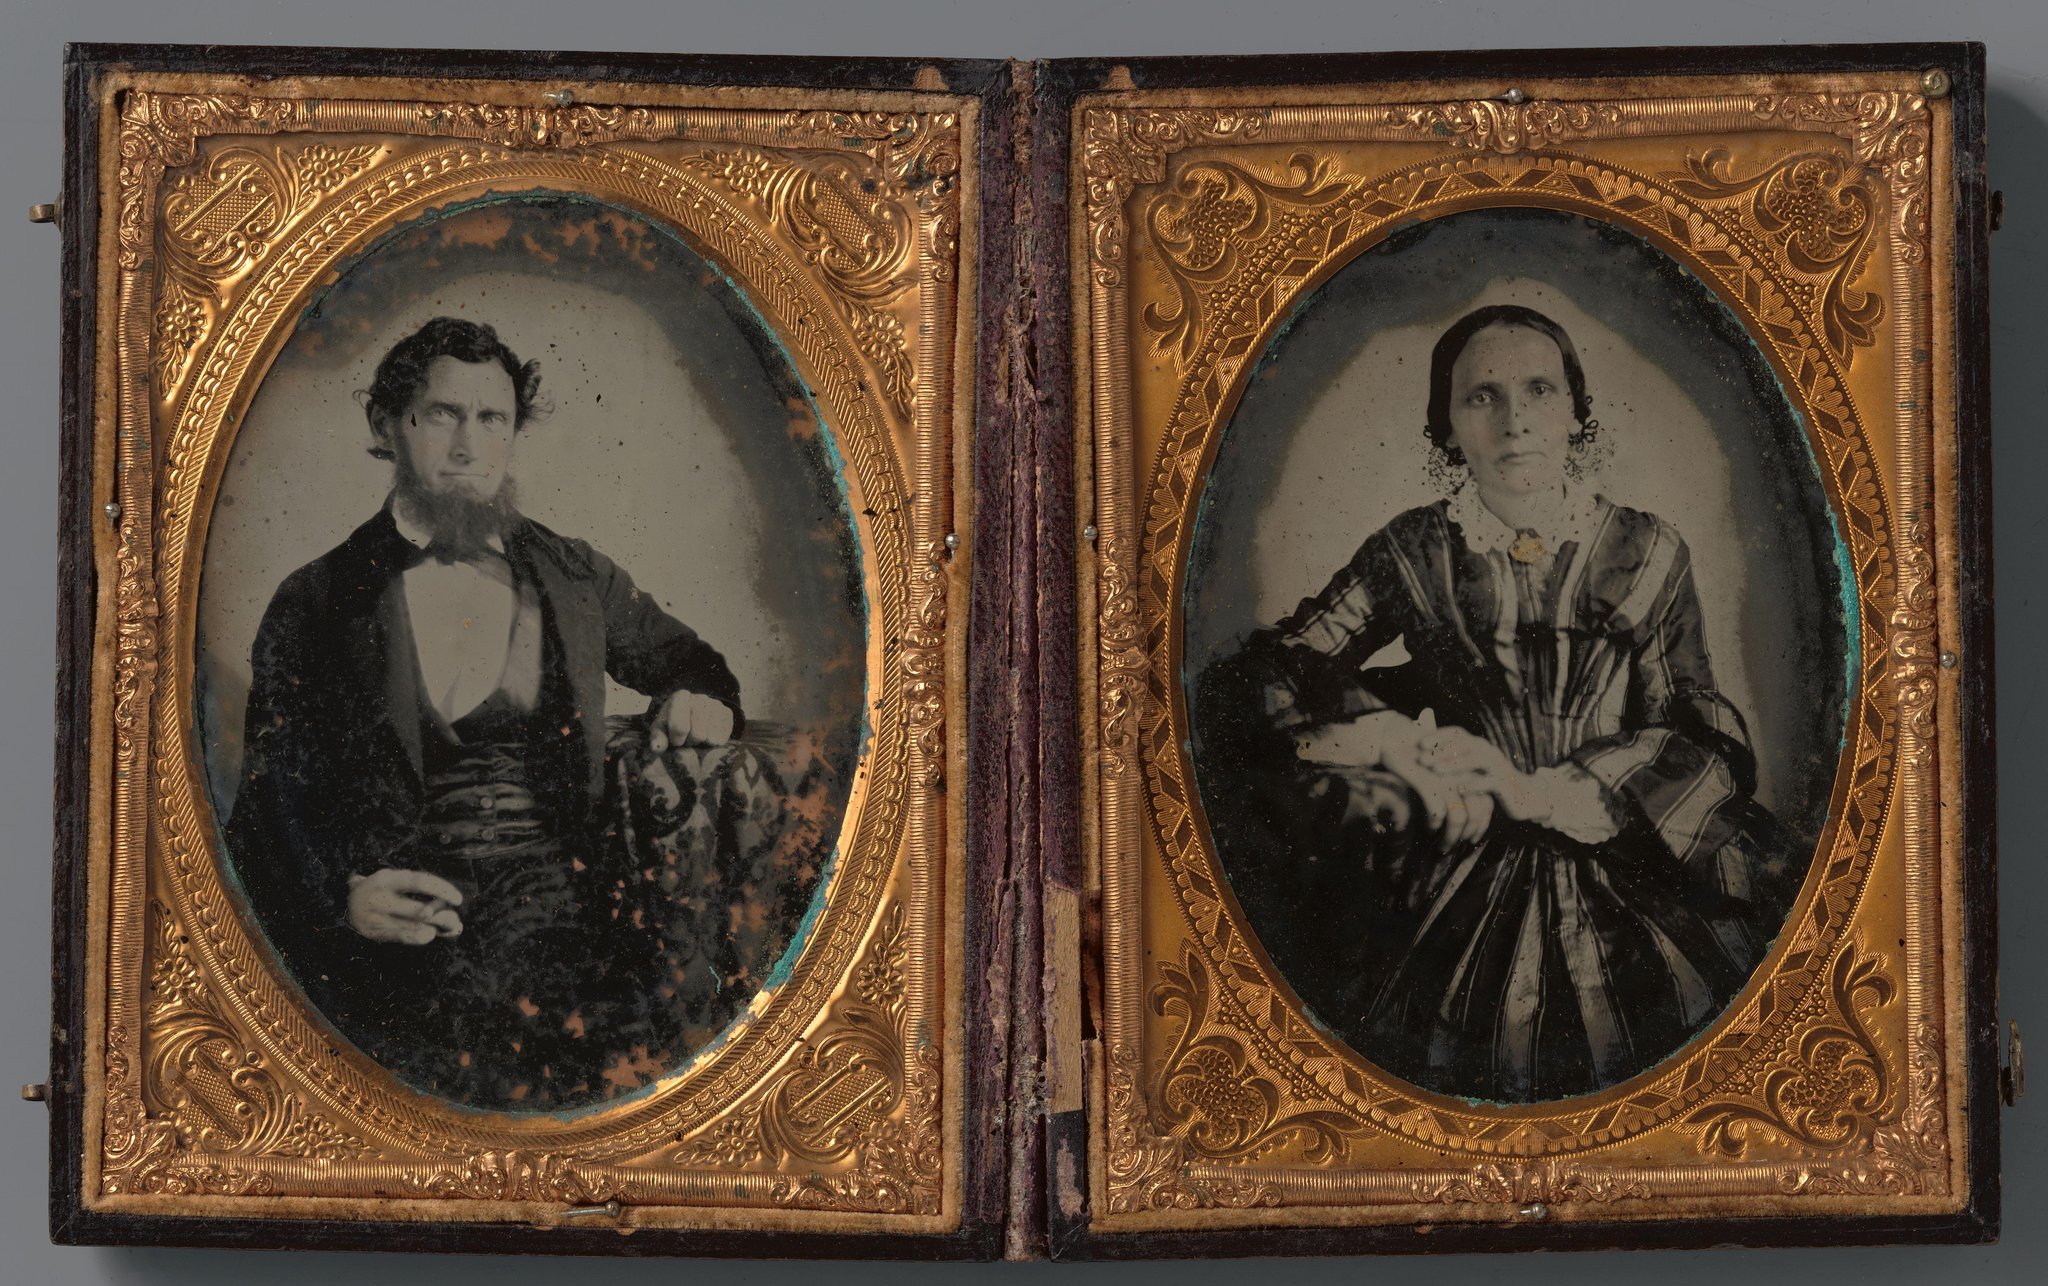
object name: photograph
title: Portret van een onbekende vrouw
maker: Anonymous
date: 1855-1870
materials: glass, metal, velvet, wood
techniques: ambrotype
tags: historical persons - bb - woman, head-gear: cap